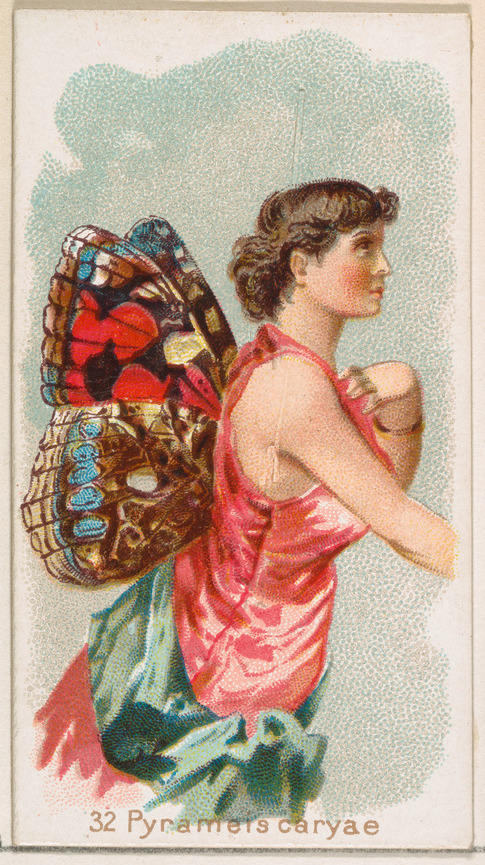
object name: print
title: Card 32, Pyrameis Caryae, from the Butterflies series (N183) issued by Wm. S. Kimball & Co.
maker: william s. kimball & company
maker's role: publisher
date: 1888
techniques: color lithograph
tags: profiles,women,butterflies